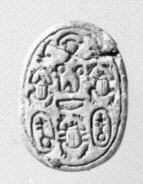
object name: stamp seal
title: Scarab seal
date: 1700-1560 BCE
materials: bone, stone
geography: levant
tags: scarabs